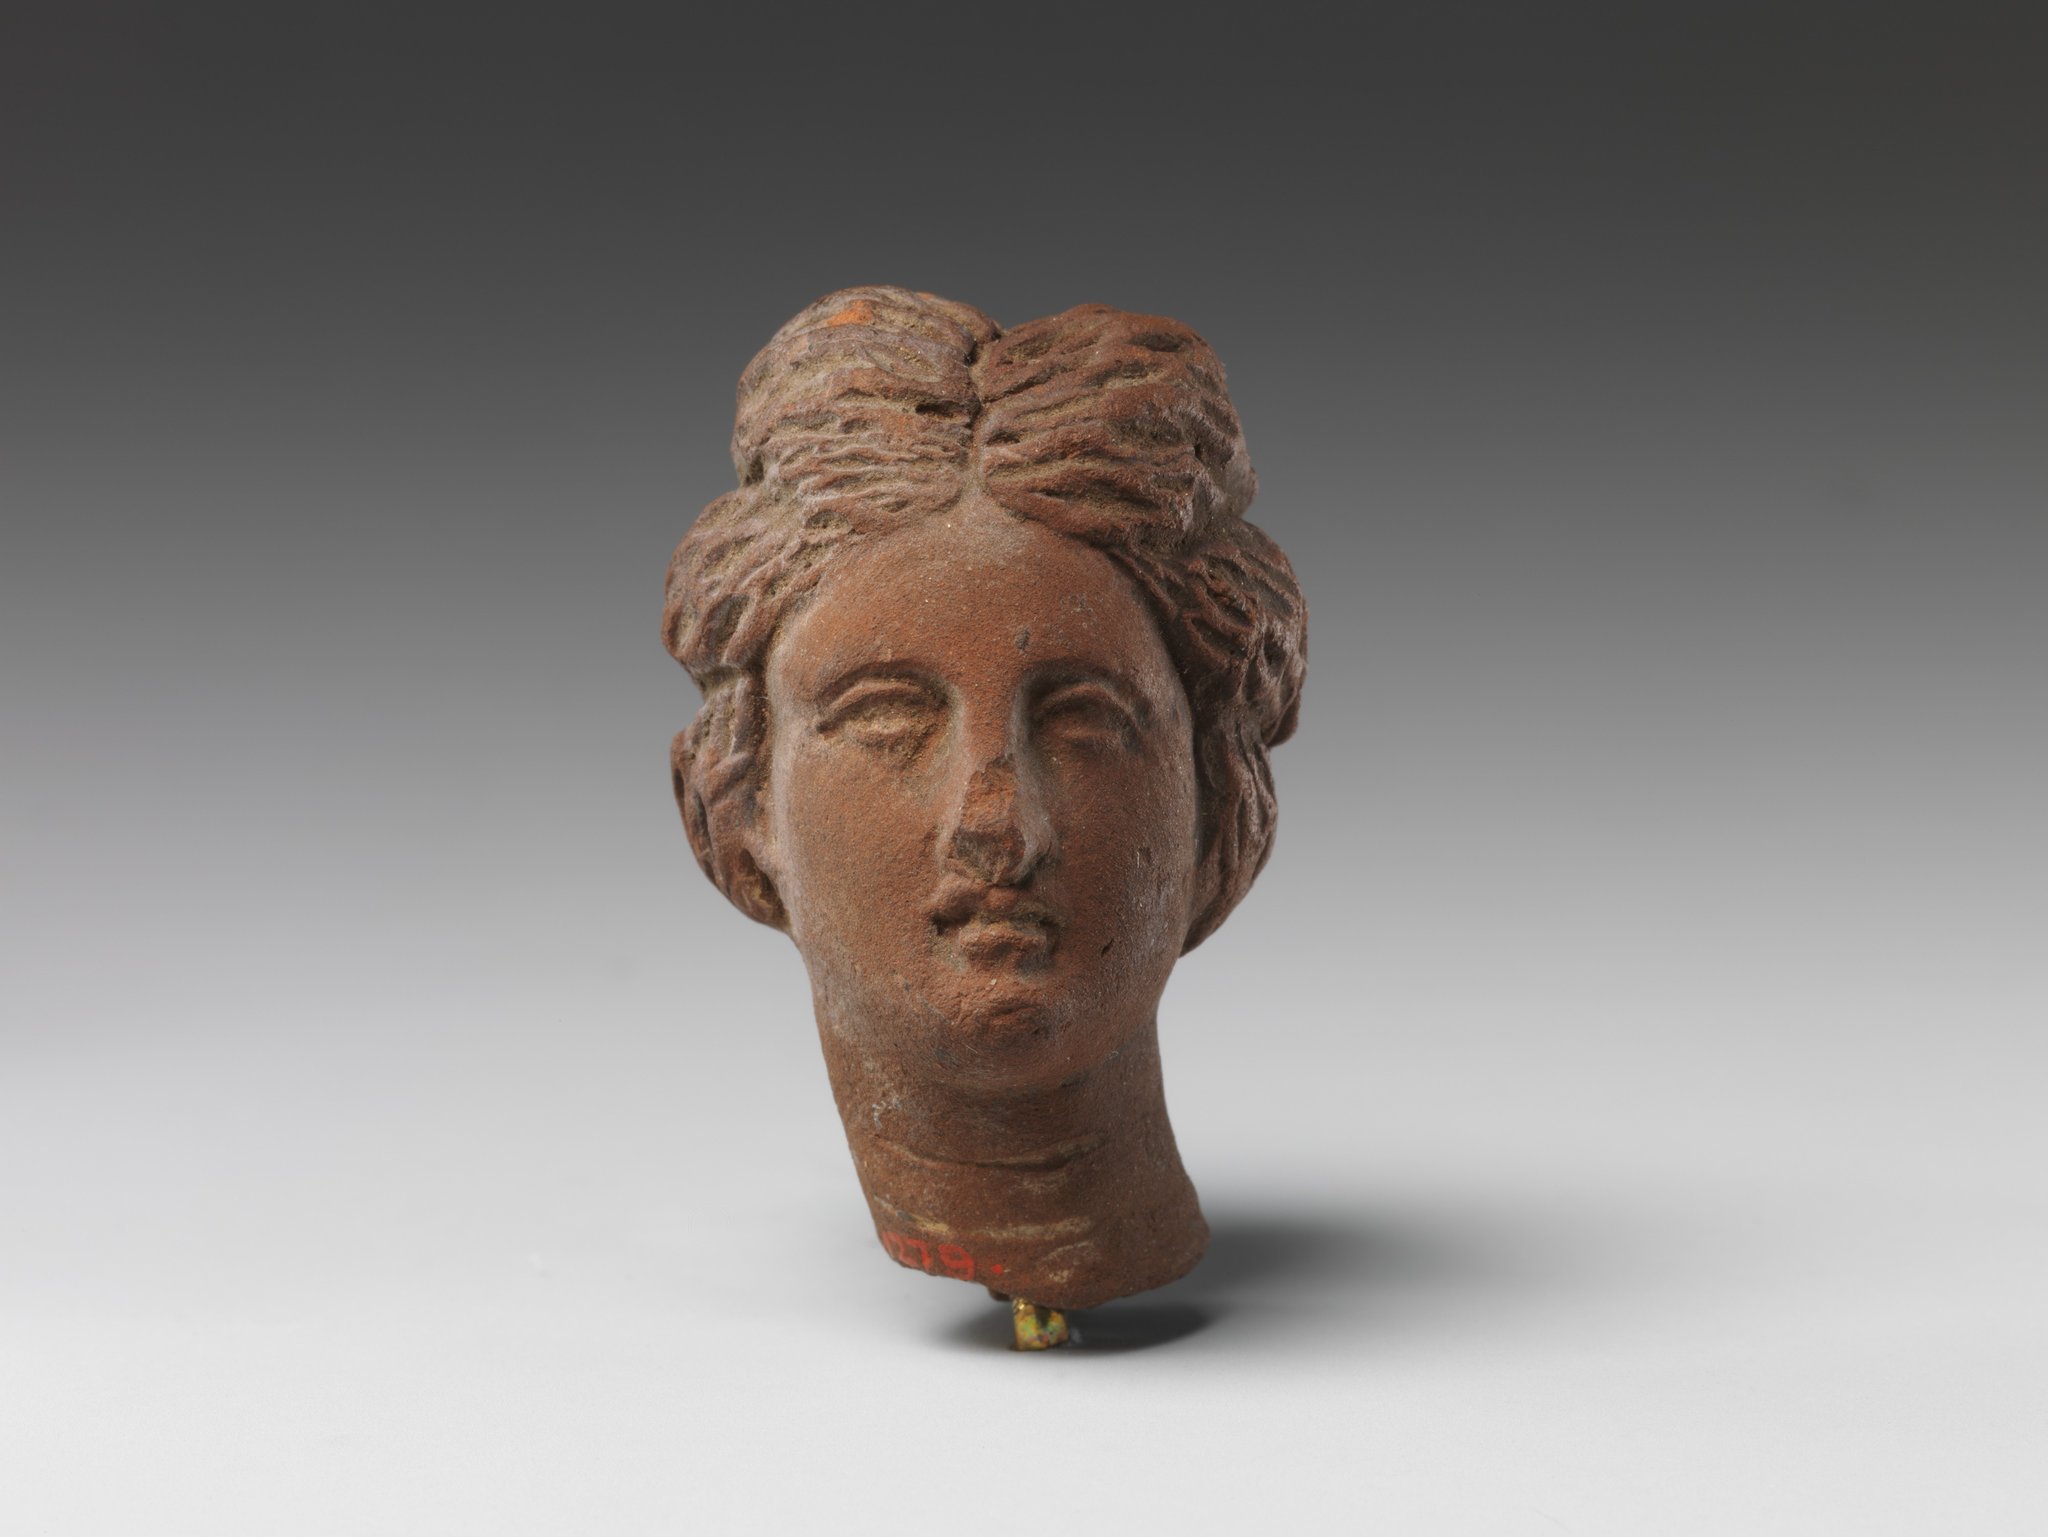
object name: head, female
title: Head of a woman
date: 300-250 BCE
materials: pottery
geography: egypt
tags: heads,women